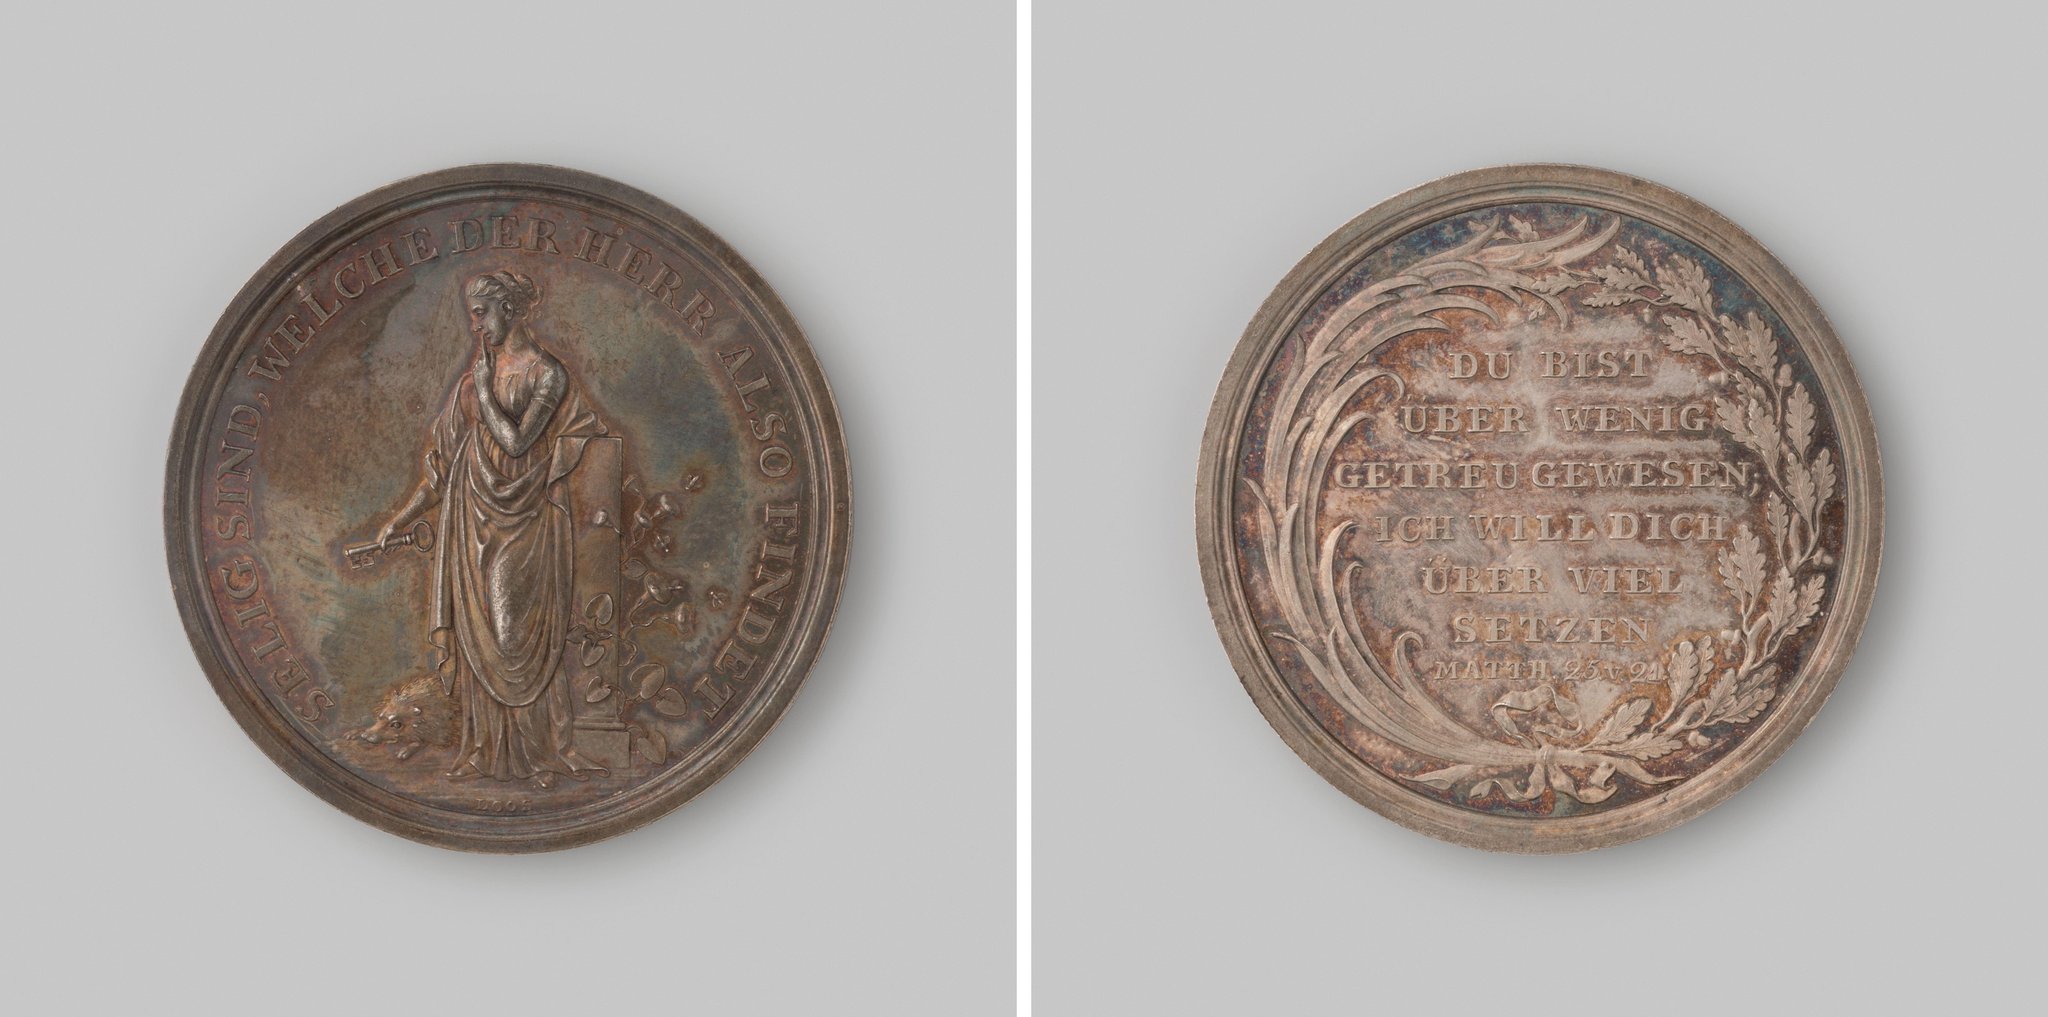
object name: history medal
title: Duitse avondmaalspenning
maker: loos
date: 1750-1850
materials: silver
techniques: striking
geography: berlin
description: Zilveren penning, op de voorzijde een vrouw met een sleutel leunend tegen een begroeide zuil, met omschrift, op de keerzijde zes regels tekst tussen samengestrikte palm- en eikentakken.